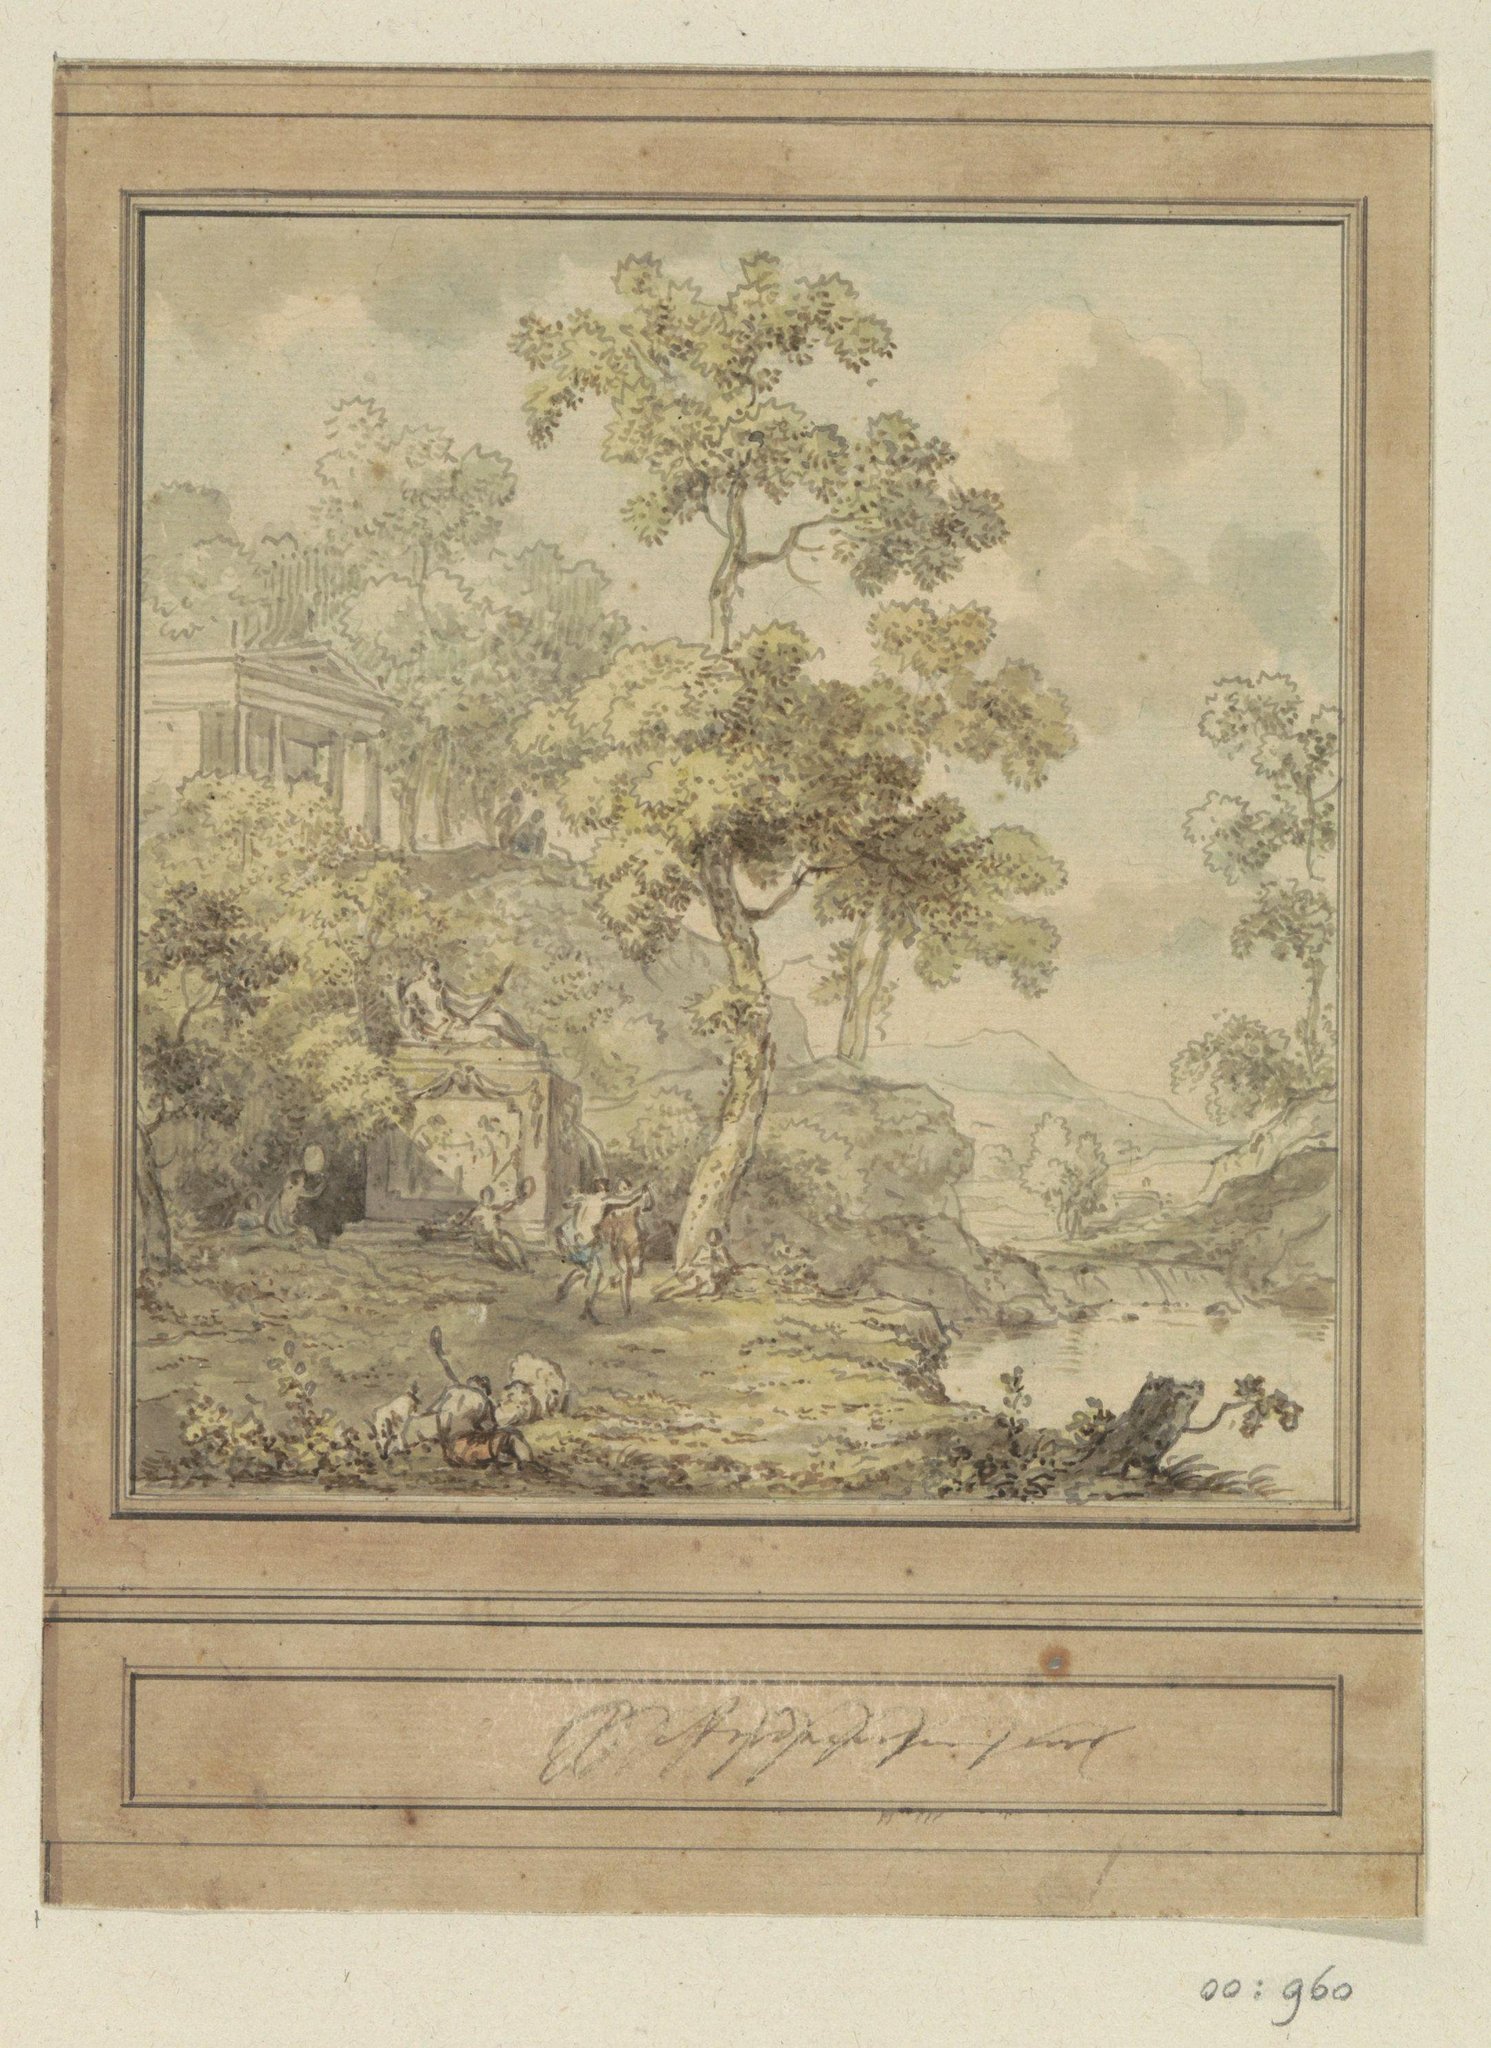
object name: drawing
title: Ontwerptekening voor een kamerwand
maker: jurriaan andriessen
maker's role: draughtsman, painter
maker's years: 1742-1819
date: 1760-1819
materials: paint, paper, pencil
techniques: brush, pen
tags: landscapes in the temperate zone, wall-covering, pastorals, arcadian scenes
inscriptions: inscription: ‘[...]’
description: Met een arcadisch landschap. Tekening maakt deel uit van een album.